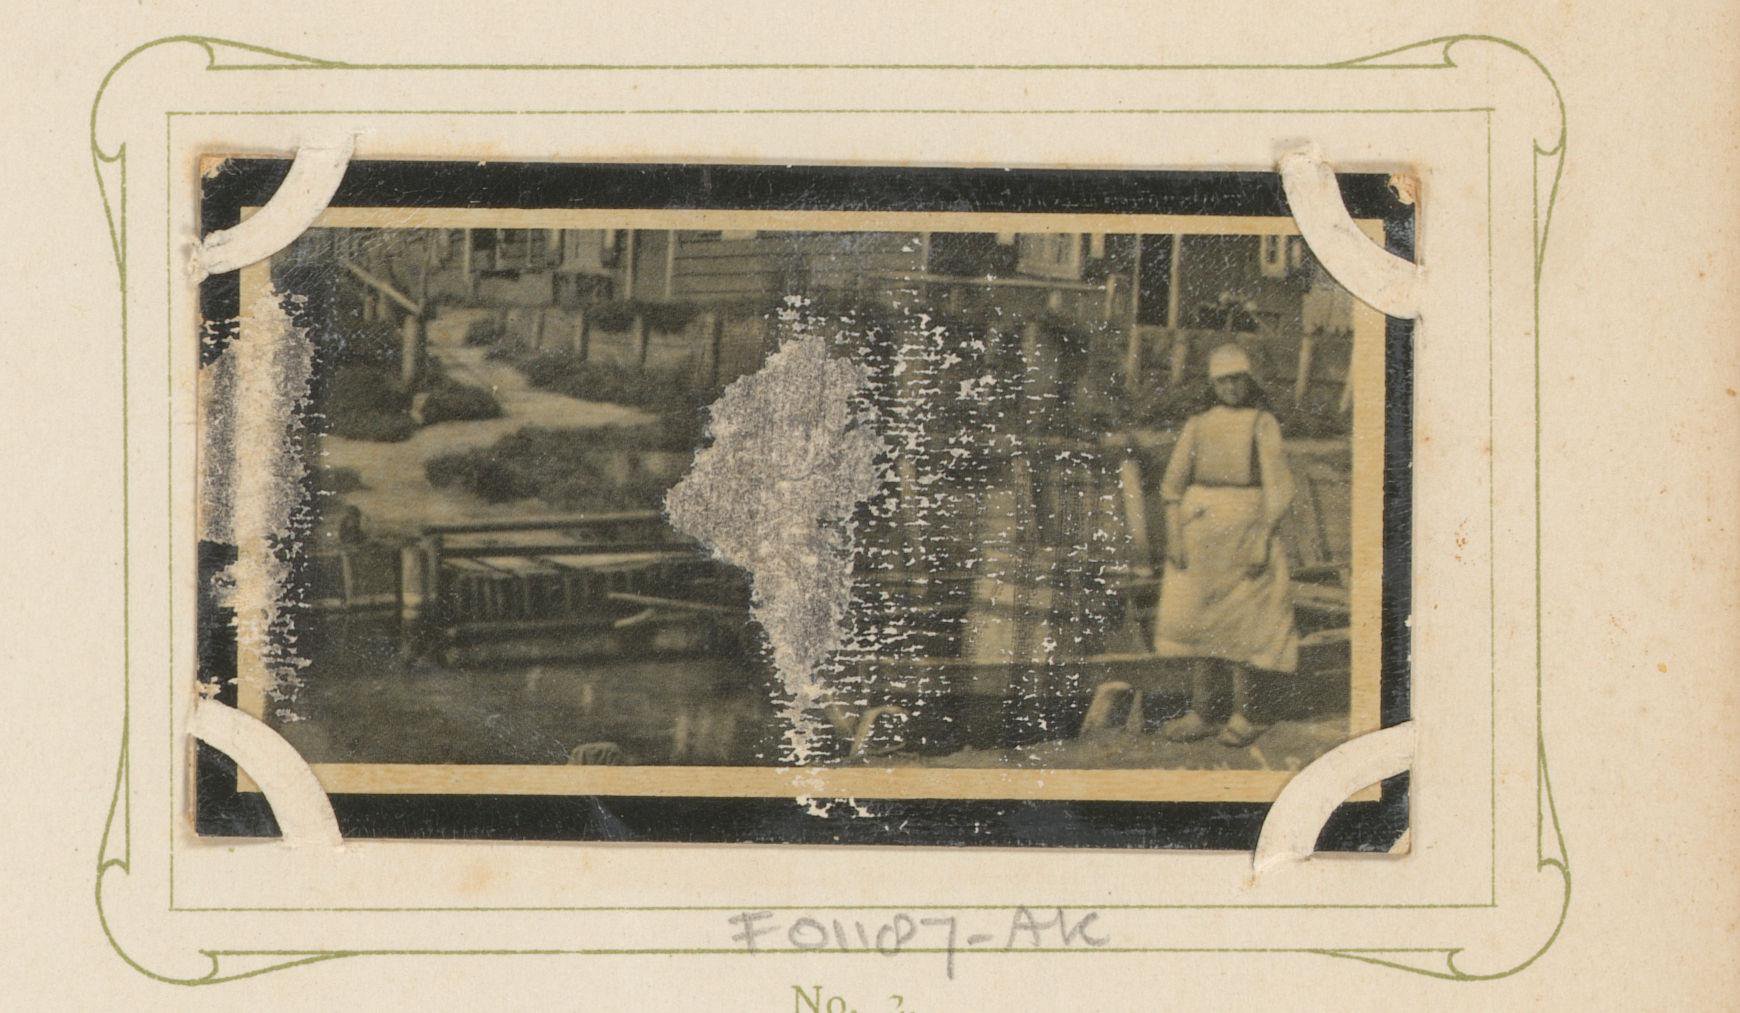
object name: album leaf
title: Vrouw bij een aangemeerde boot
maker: Anonymous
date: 1905-1906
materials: paper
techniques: photograph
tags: adult woman, rowing-boat, canoe, etc., pier, quay, wharf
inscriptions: inscription: ‘No. 2./ Buurtje.’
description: Deze prent maakt deel uit van een album.